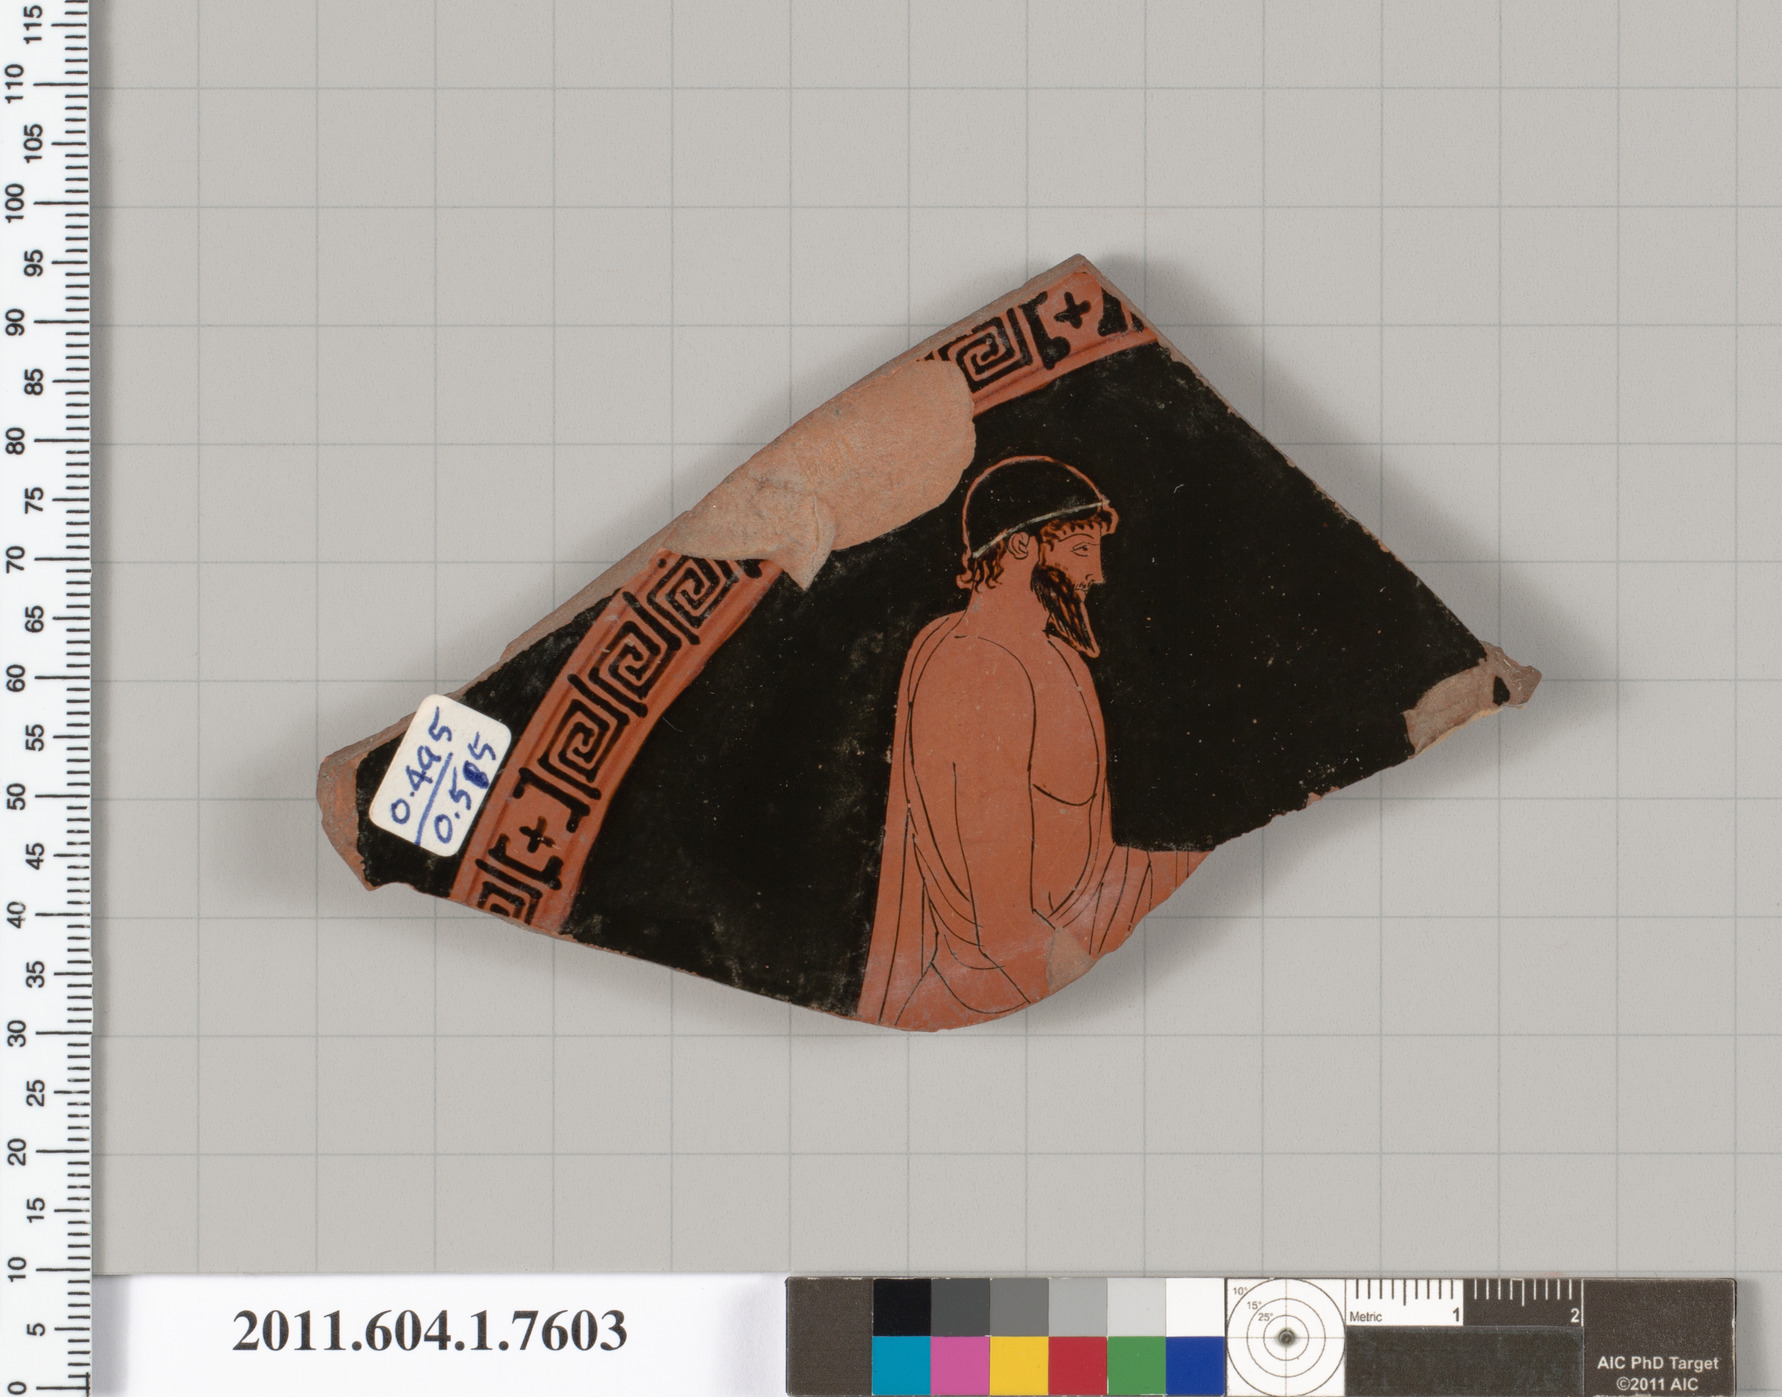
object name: kylix fragment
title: Terracotta fragment of a kylix (drinking cup)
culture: greek, attic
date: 460-450 BCE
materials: terracotta